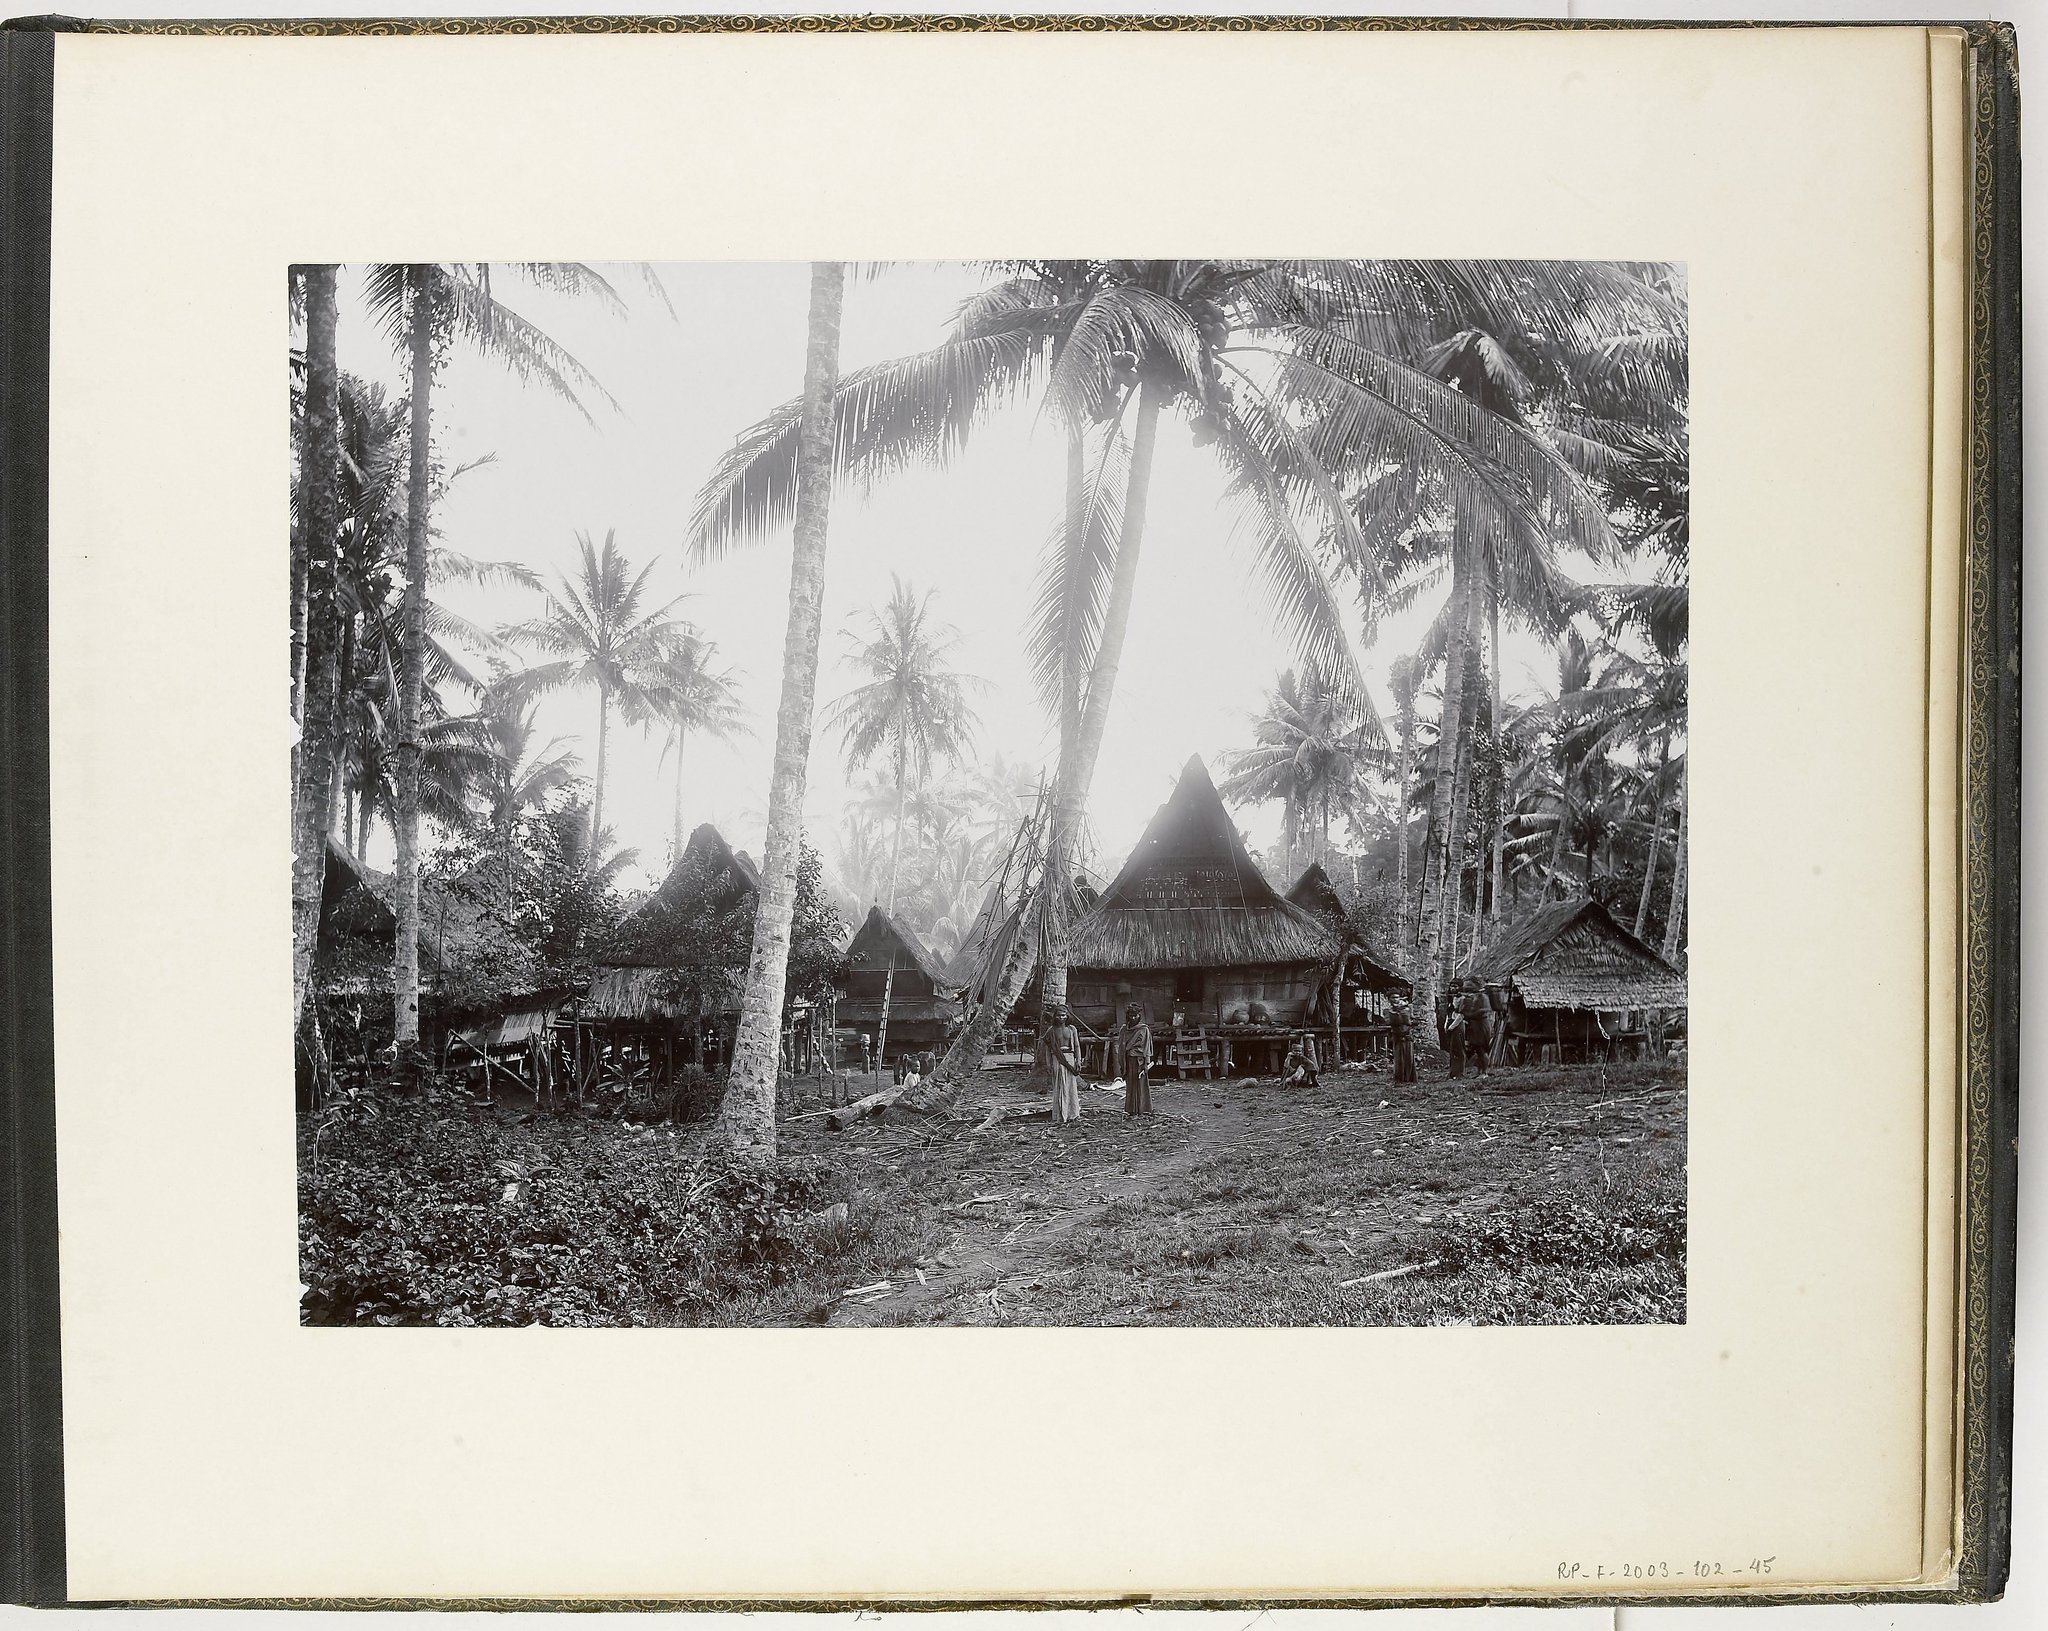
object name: photograph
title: Gezicht op Battak Kampong Poeloe Hawar, Sumatra (Battak Kampong Poeloe Hawar)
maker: carl j. kleingrothe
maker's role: fotograaf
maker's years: 1864-1925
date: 1885-1900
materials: photographic support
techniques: collodion silver print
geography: sumatra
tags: sumatra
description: Huizen en inwoners van het Batakdorp Poeloe Hawar op Sumatra. Onderdeel van het Sumatra fotoalbum van Paul en Lucie Sandel uit 1900.